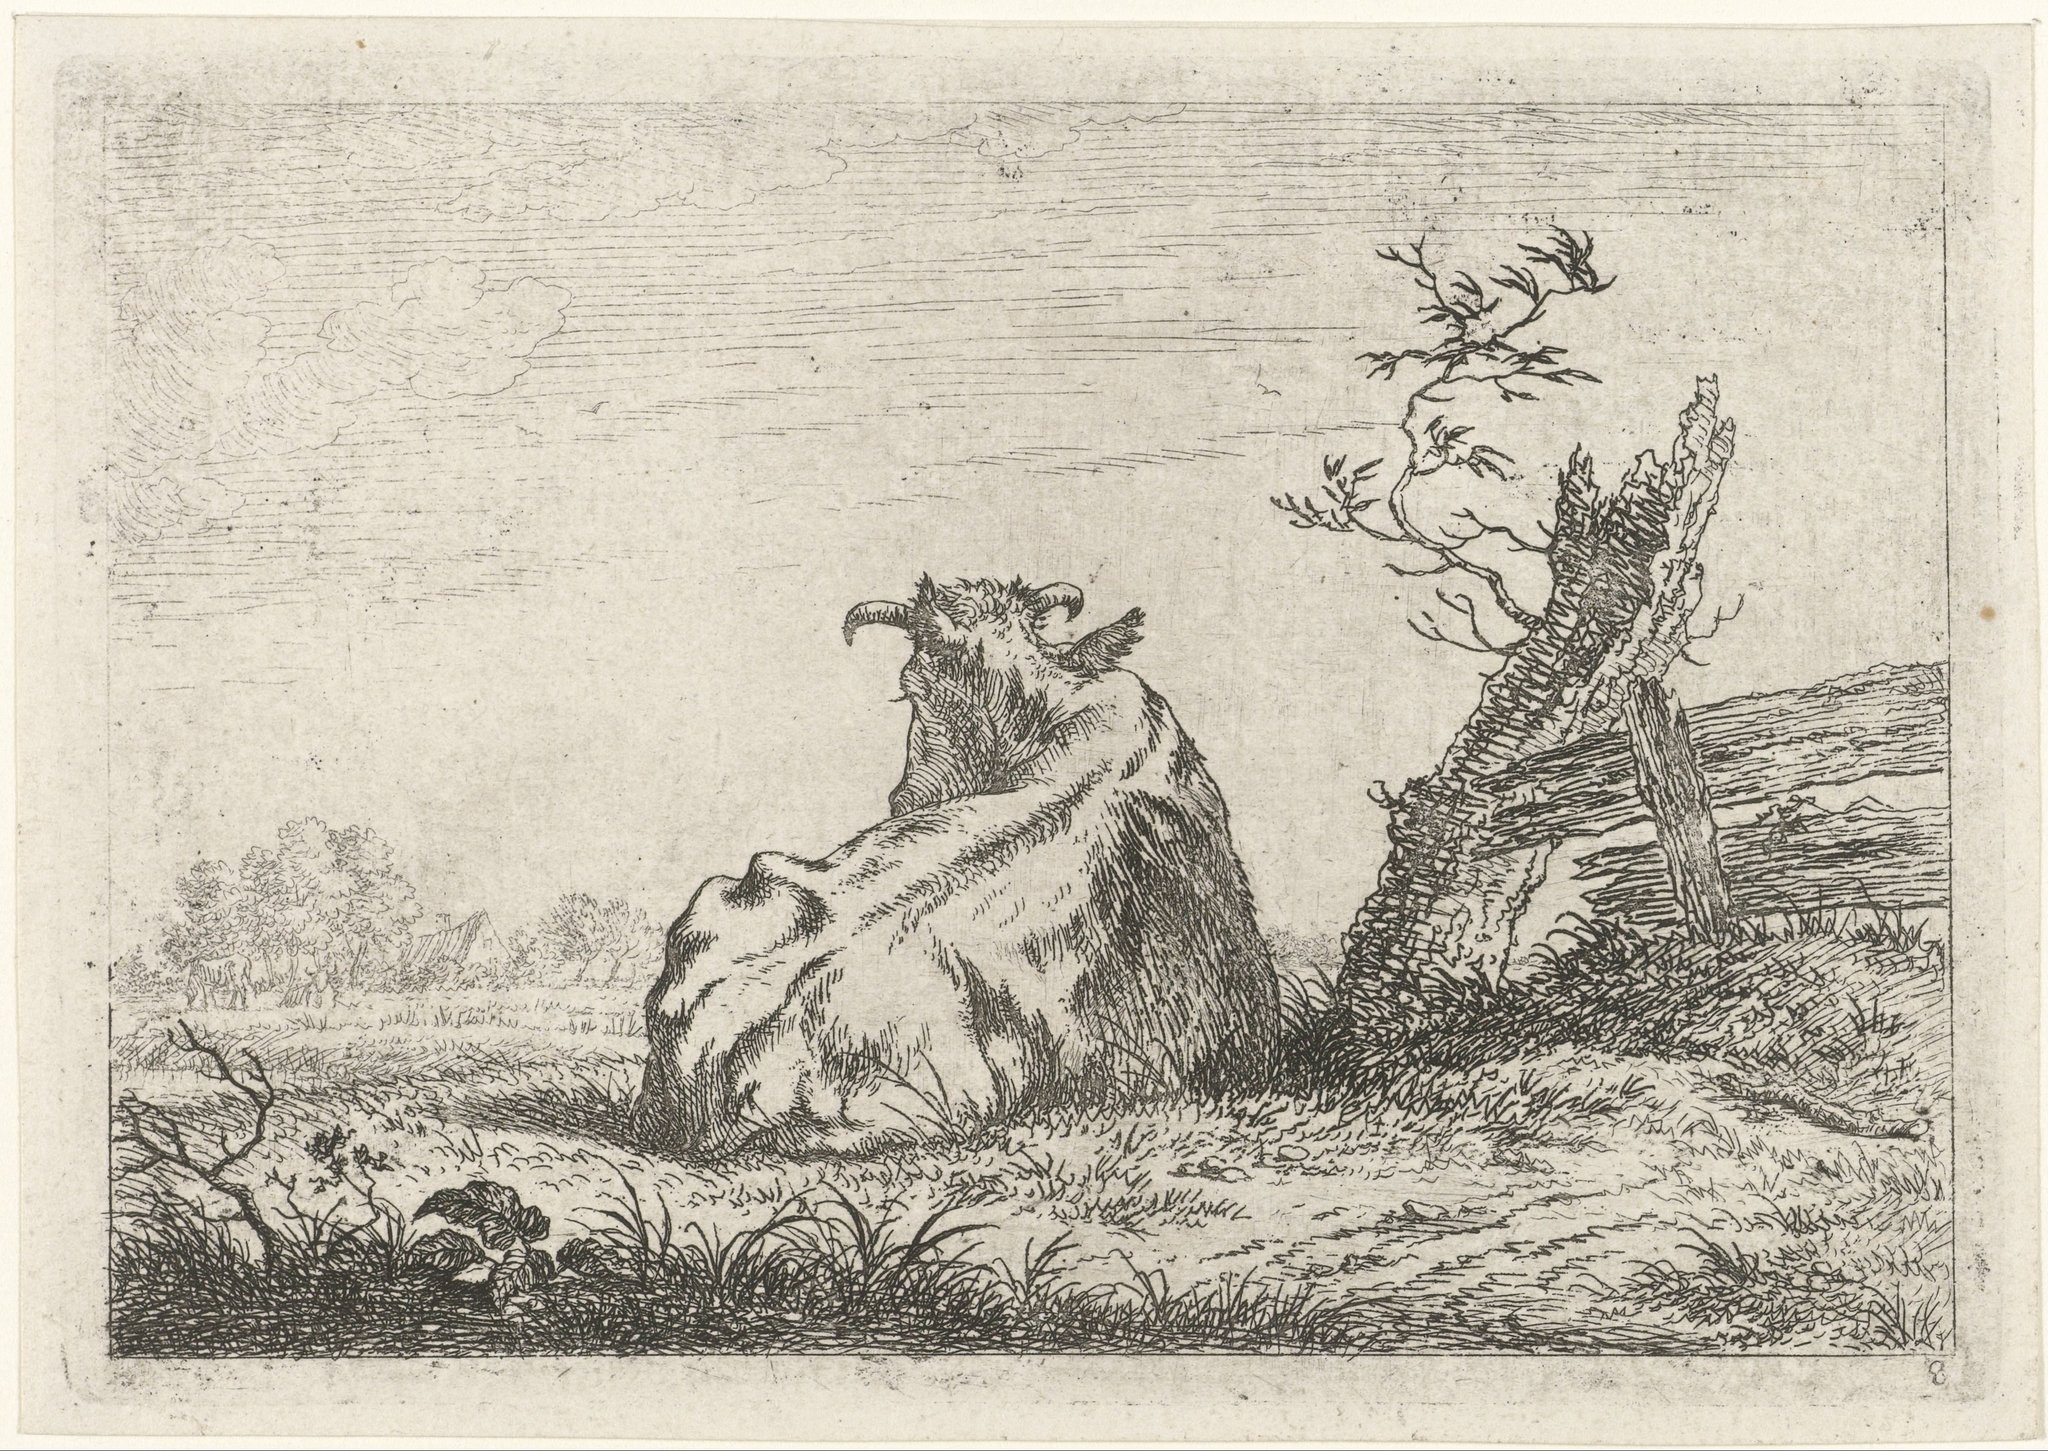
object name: print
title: Landschappen met vee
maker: johannes janson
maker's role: draughtsman, painter, print maker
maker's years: 1729-1784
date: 1761-1784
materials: paper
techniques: etching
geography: leiden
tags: cow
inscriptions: collector's mark: Lugt 2228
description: Weiland met liggende koe, op de rug gezien. Rechts een hek, boomstronk en tak. Achtste prent uit een serie van acht met landschappen met vee.